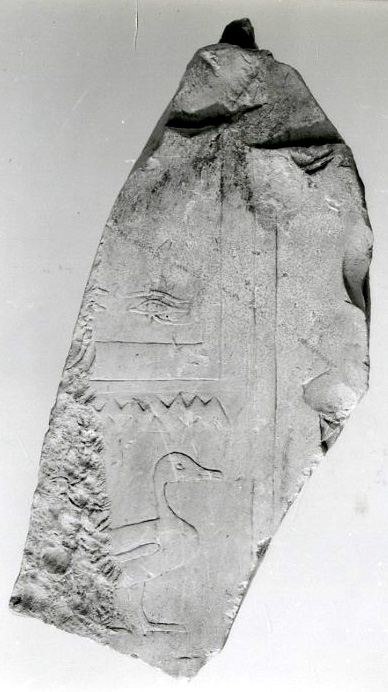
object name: relief fragment, tomb of meketre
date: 1981-1975 BCE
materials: limestone, paint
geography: egypt